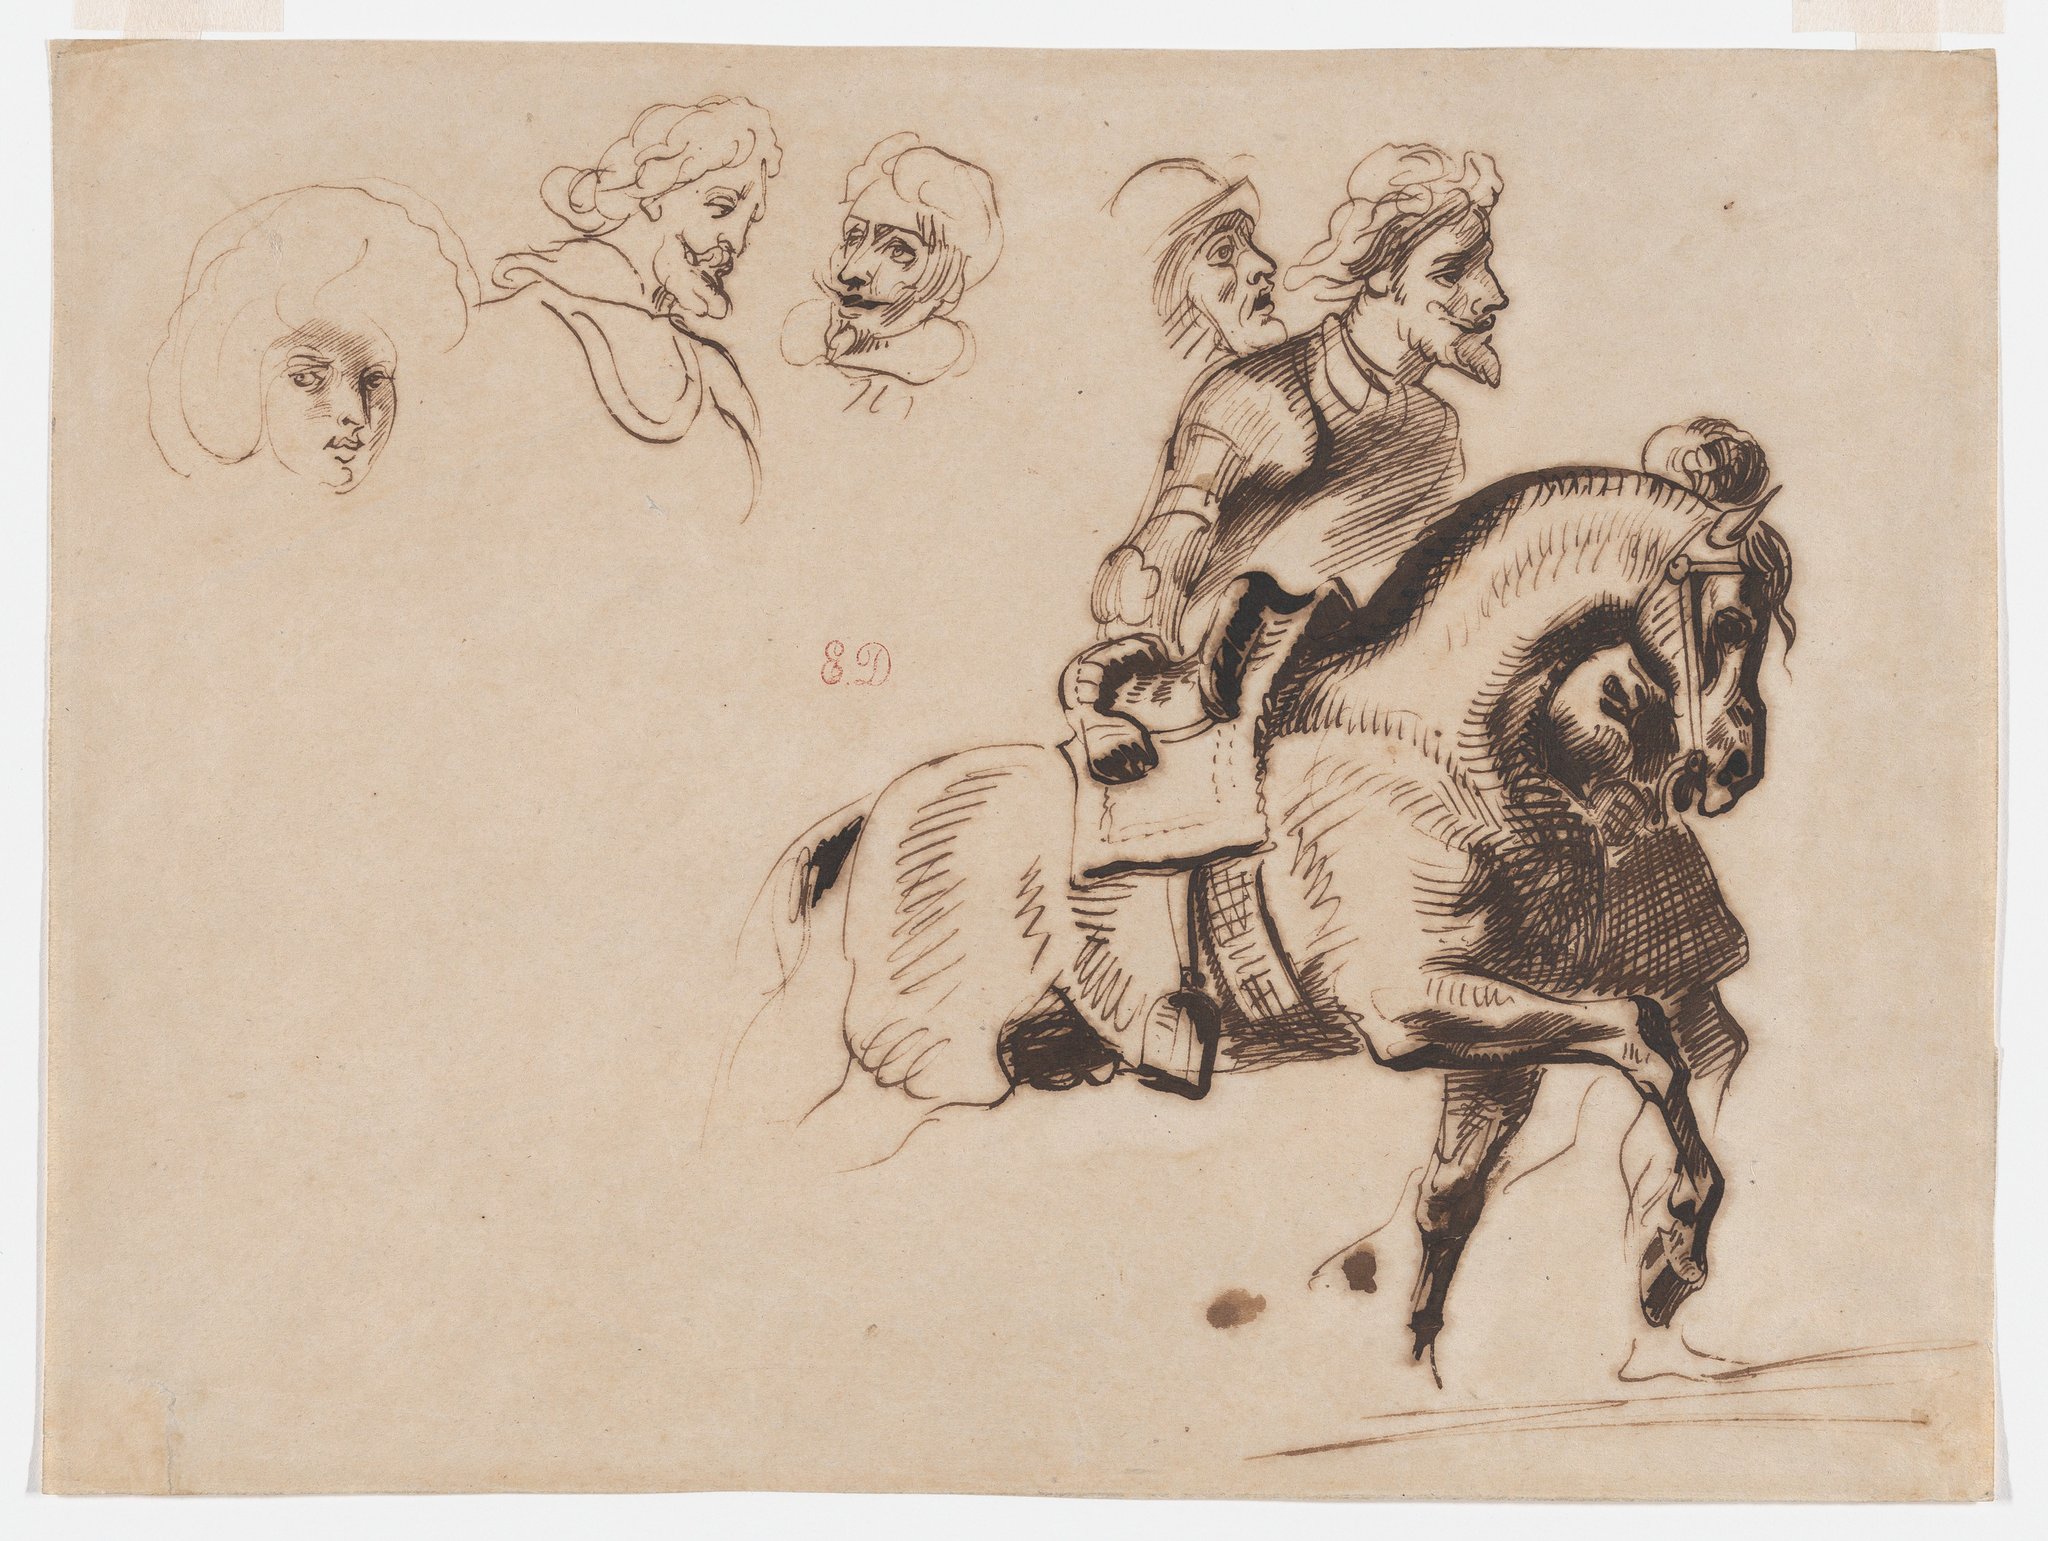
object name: drawing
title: Studies of a Medieval Horse and Rider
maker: eugène delacroix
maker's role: artist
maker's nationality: french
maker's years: 1798-1863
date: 1824-1830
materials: ink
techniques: pen